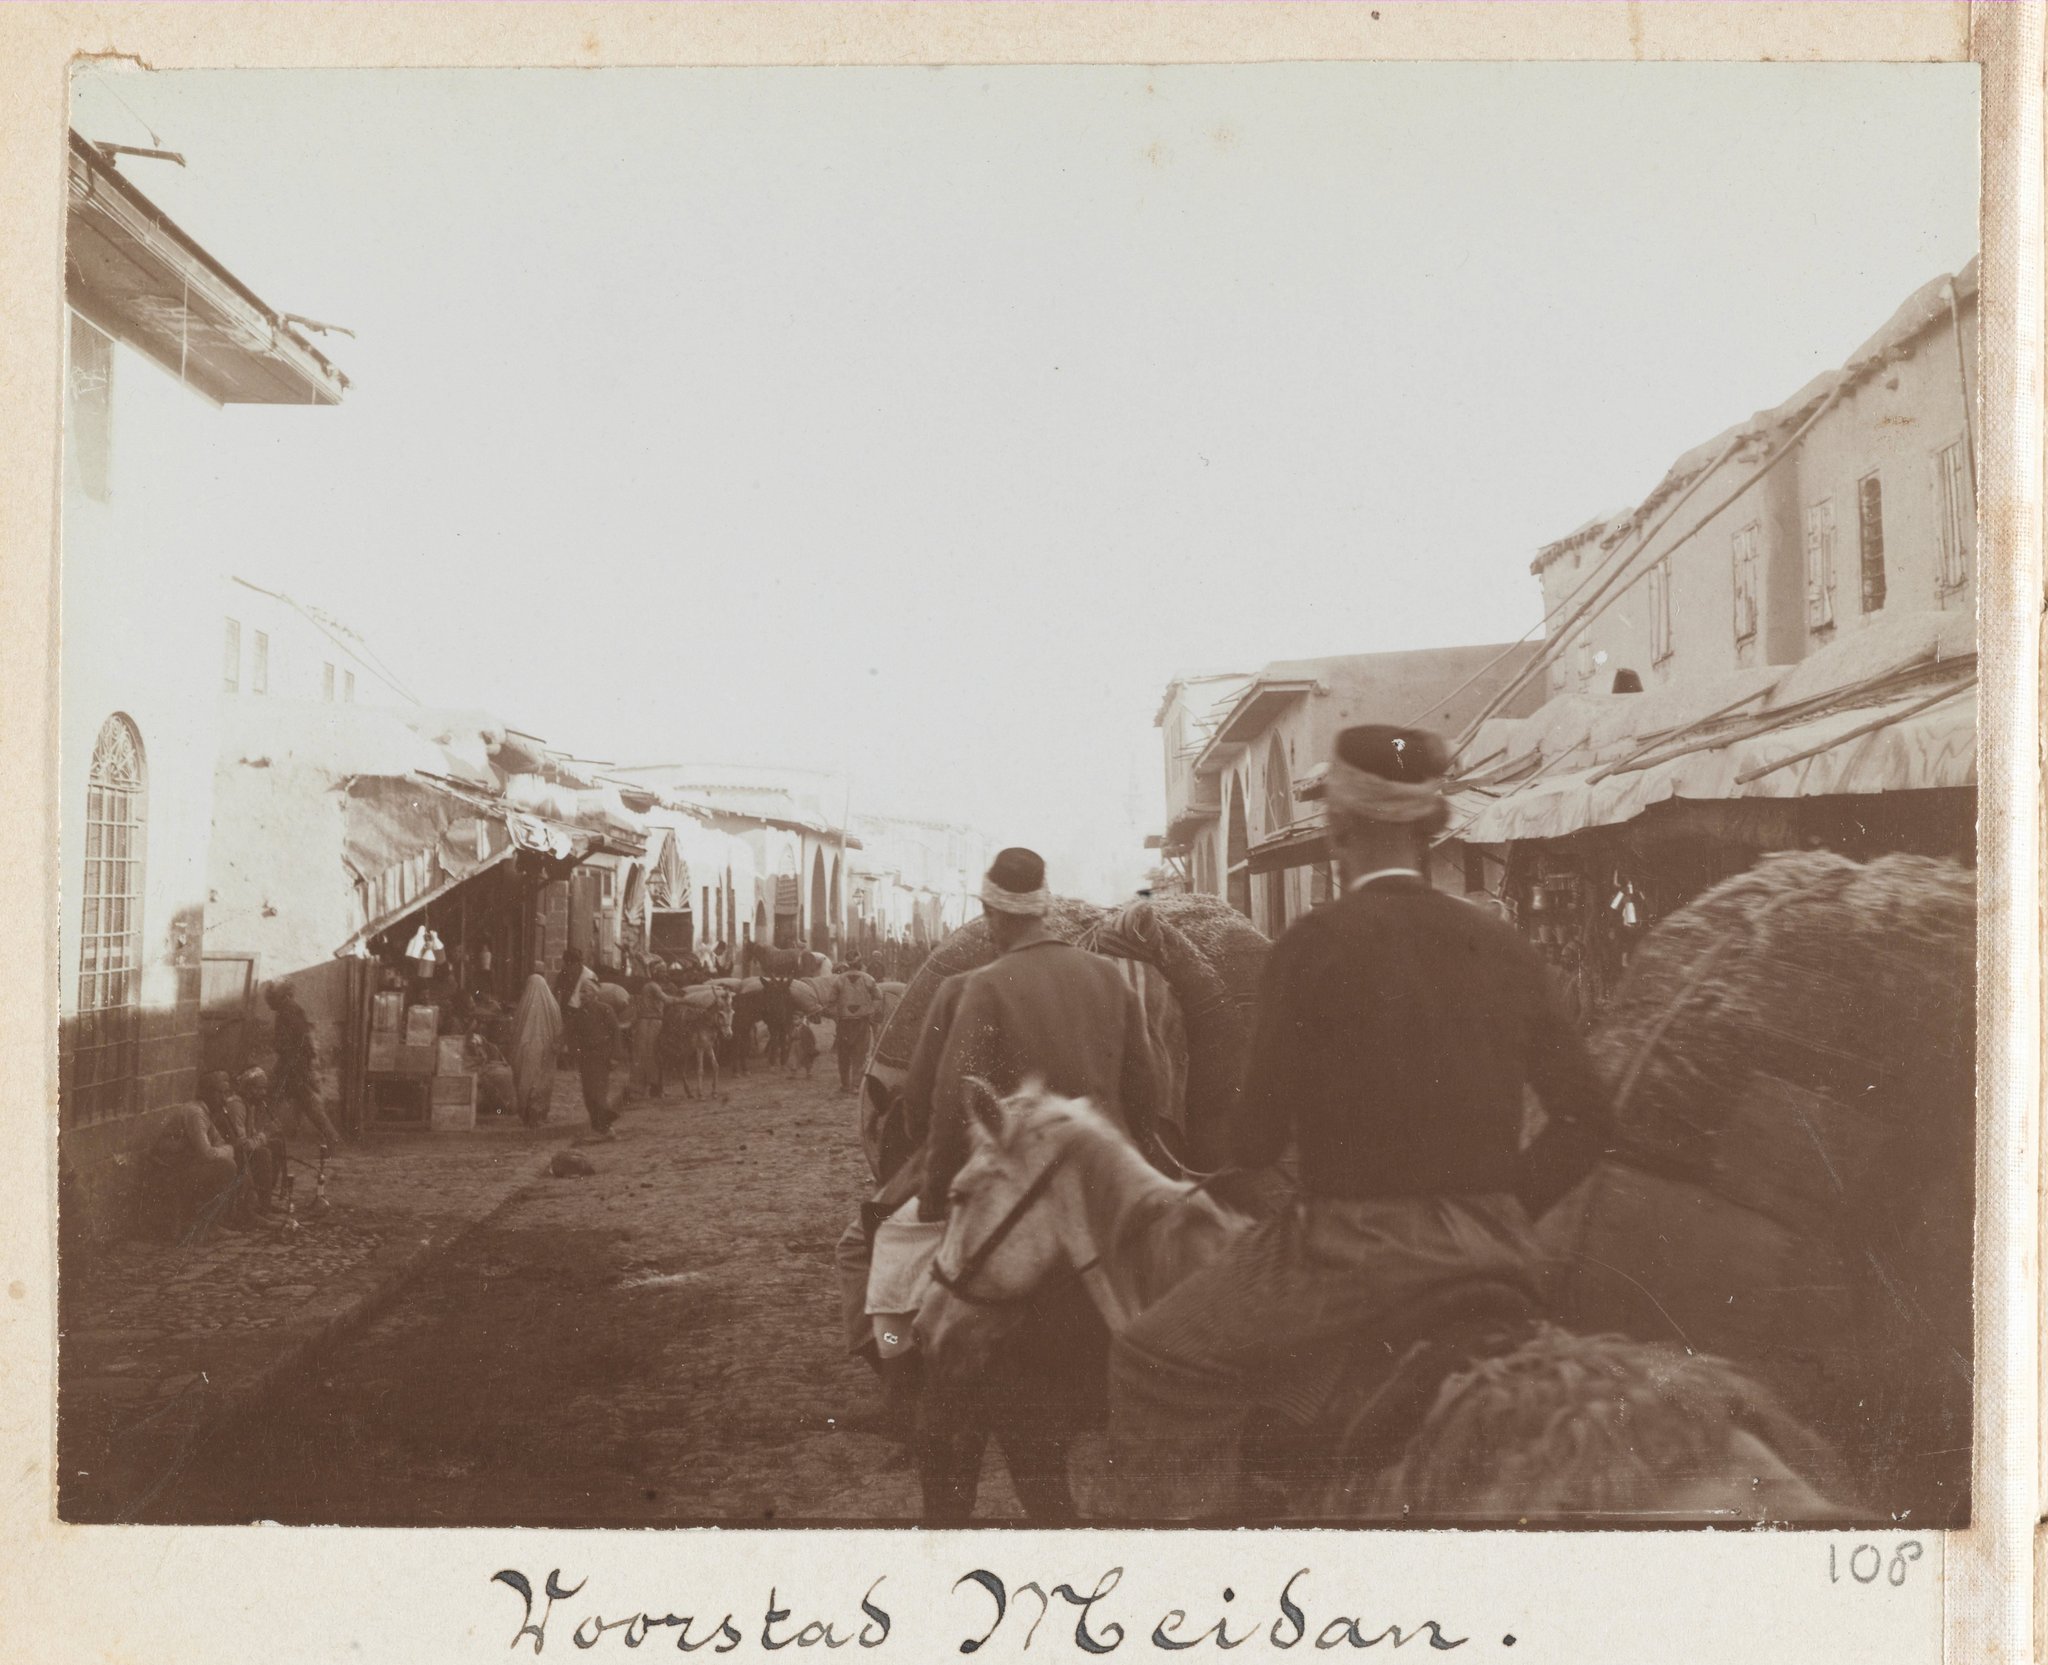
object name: page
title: Voorstad Meidan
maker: johannes lodewijk heldring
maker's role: fotograaf, predikant, schrijver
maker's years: 1852-1923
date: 1898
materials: paper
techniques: collodion silver print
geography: al-midan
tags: village street